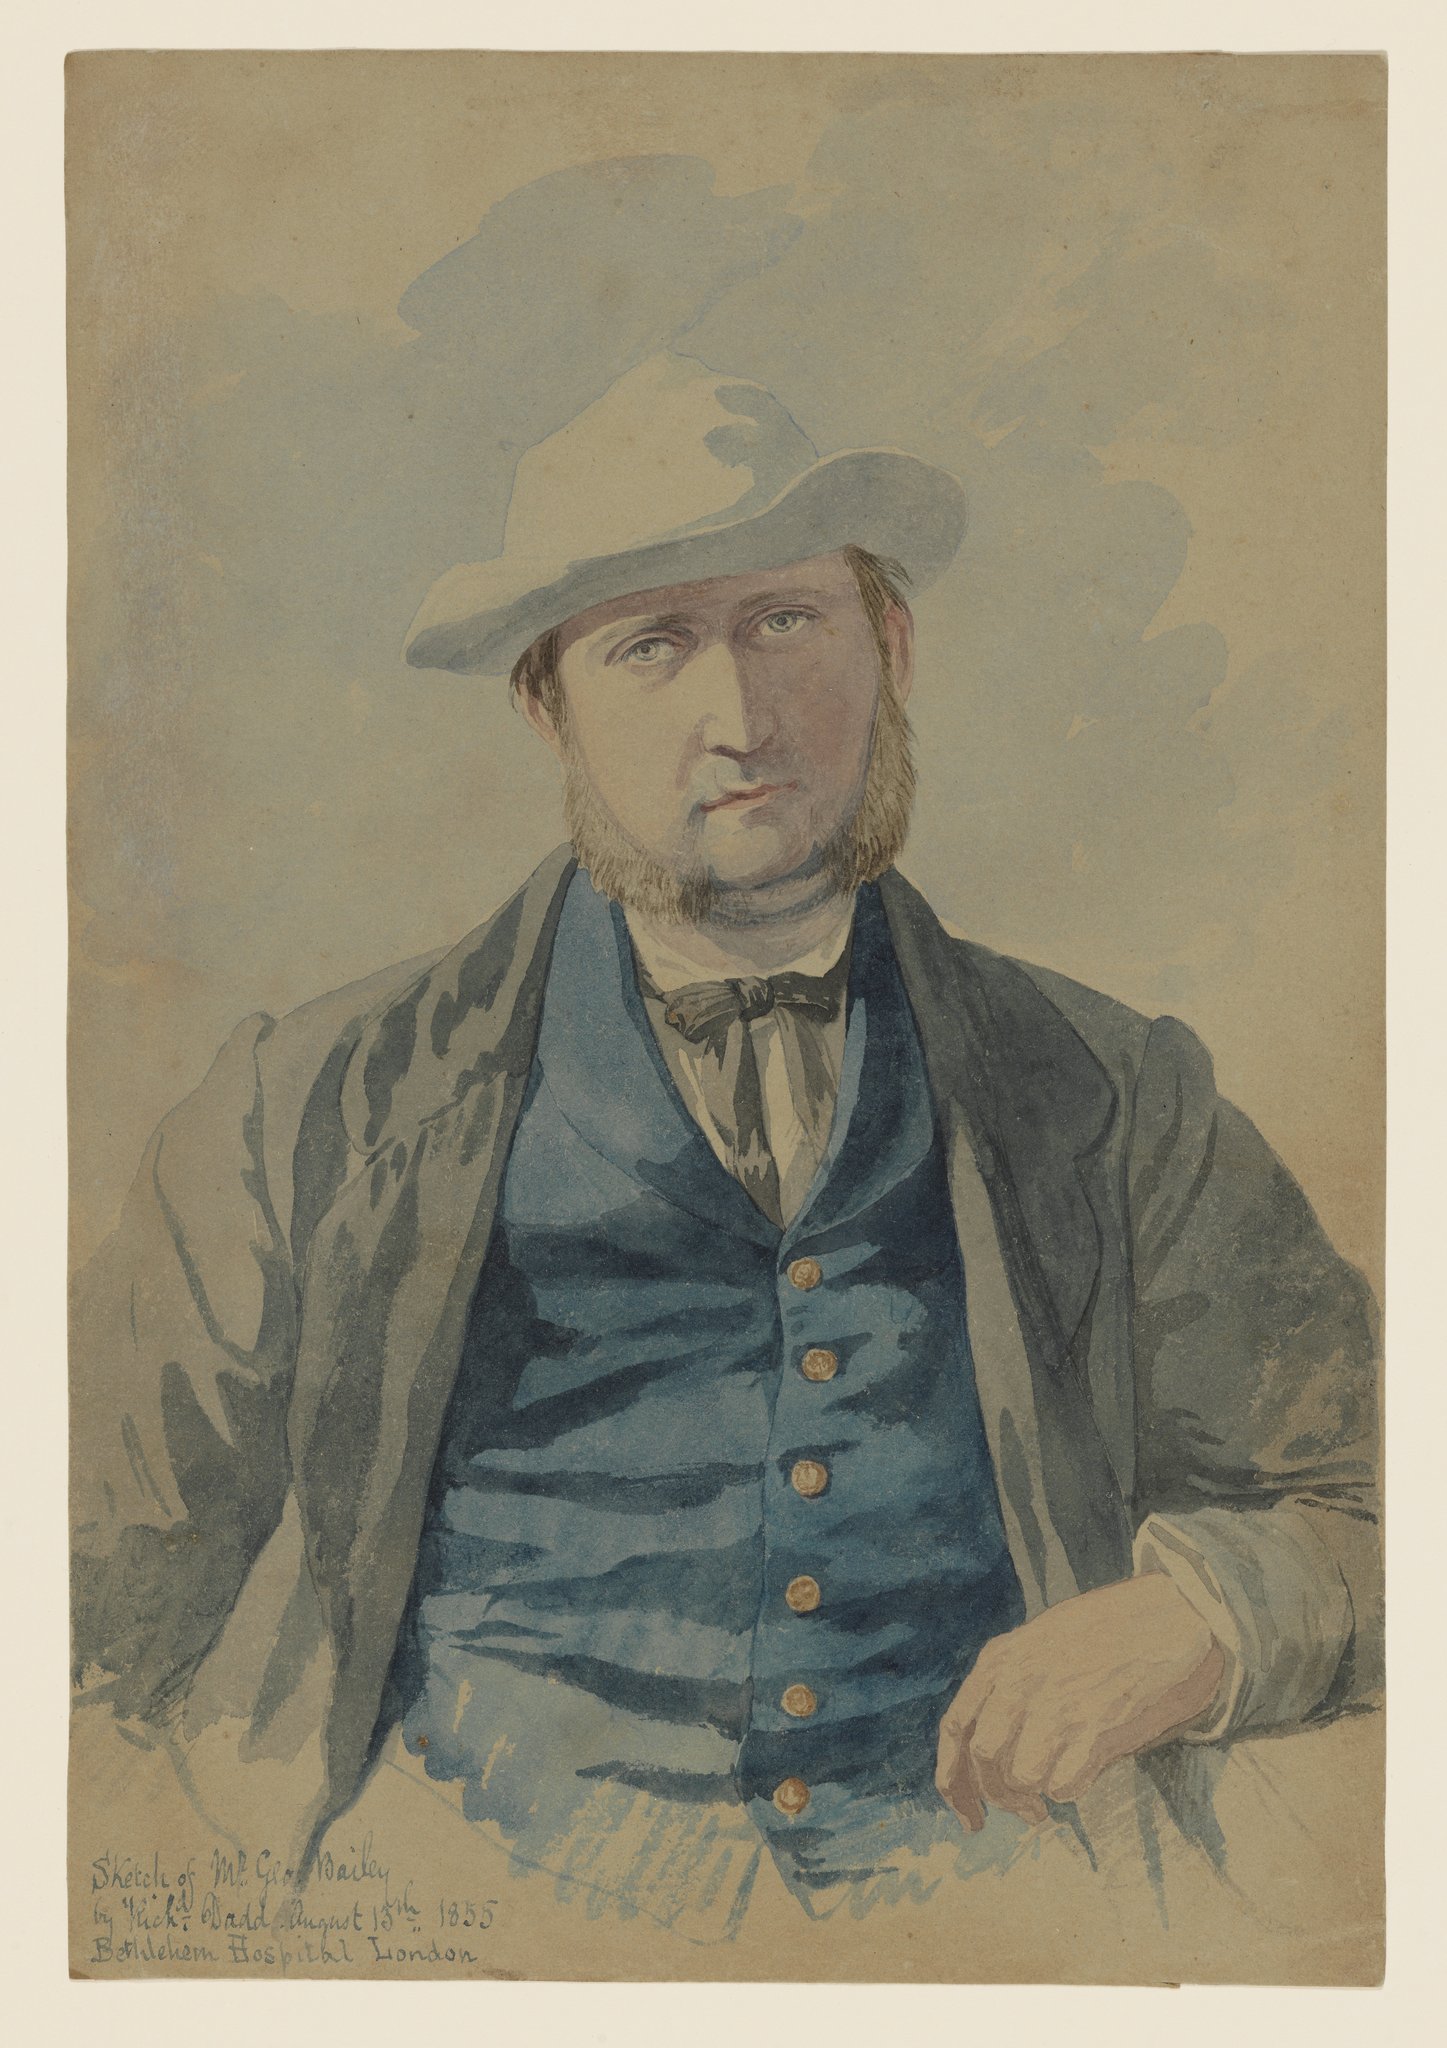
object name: drawing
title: Portrait of Mr. George Bailey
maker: richard dadd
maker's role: artist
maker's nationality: british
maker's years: 1817-1886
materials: watercolor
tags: men,portraits